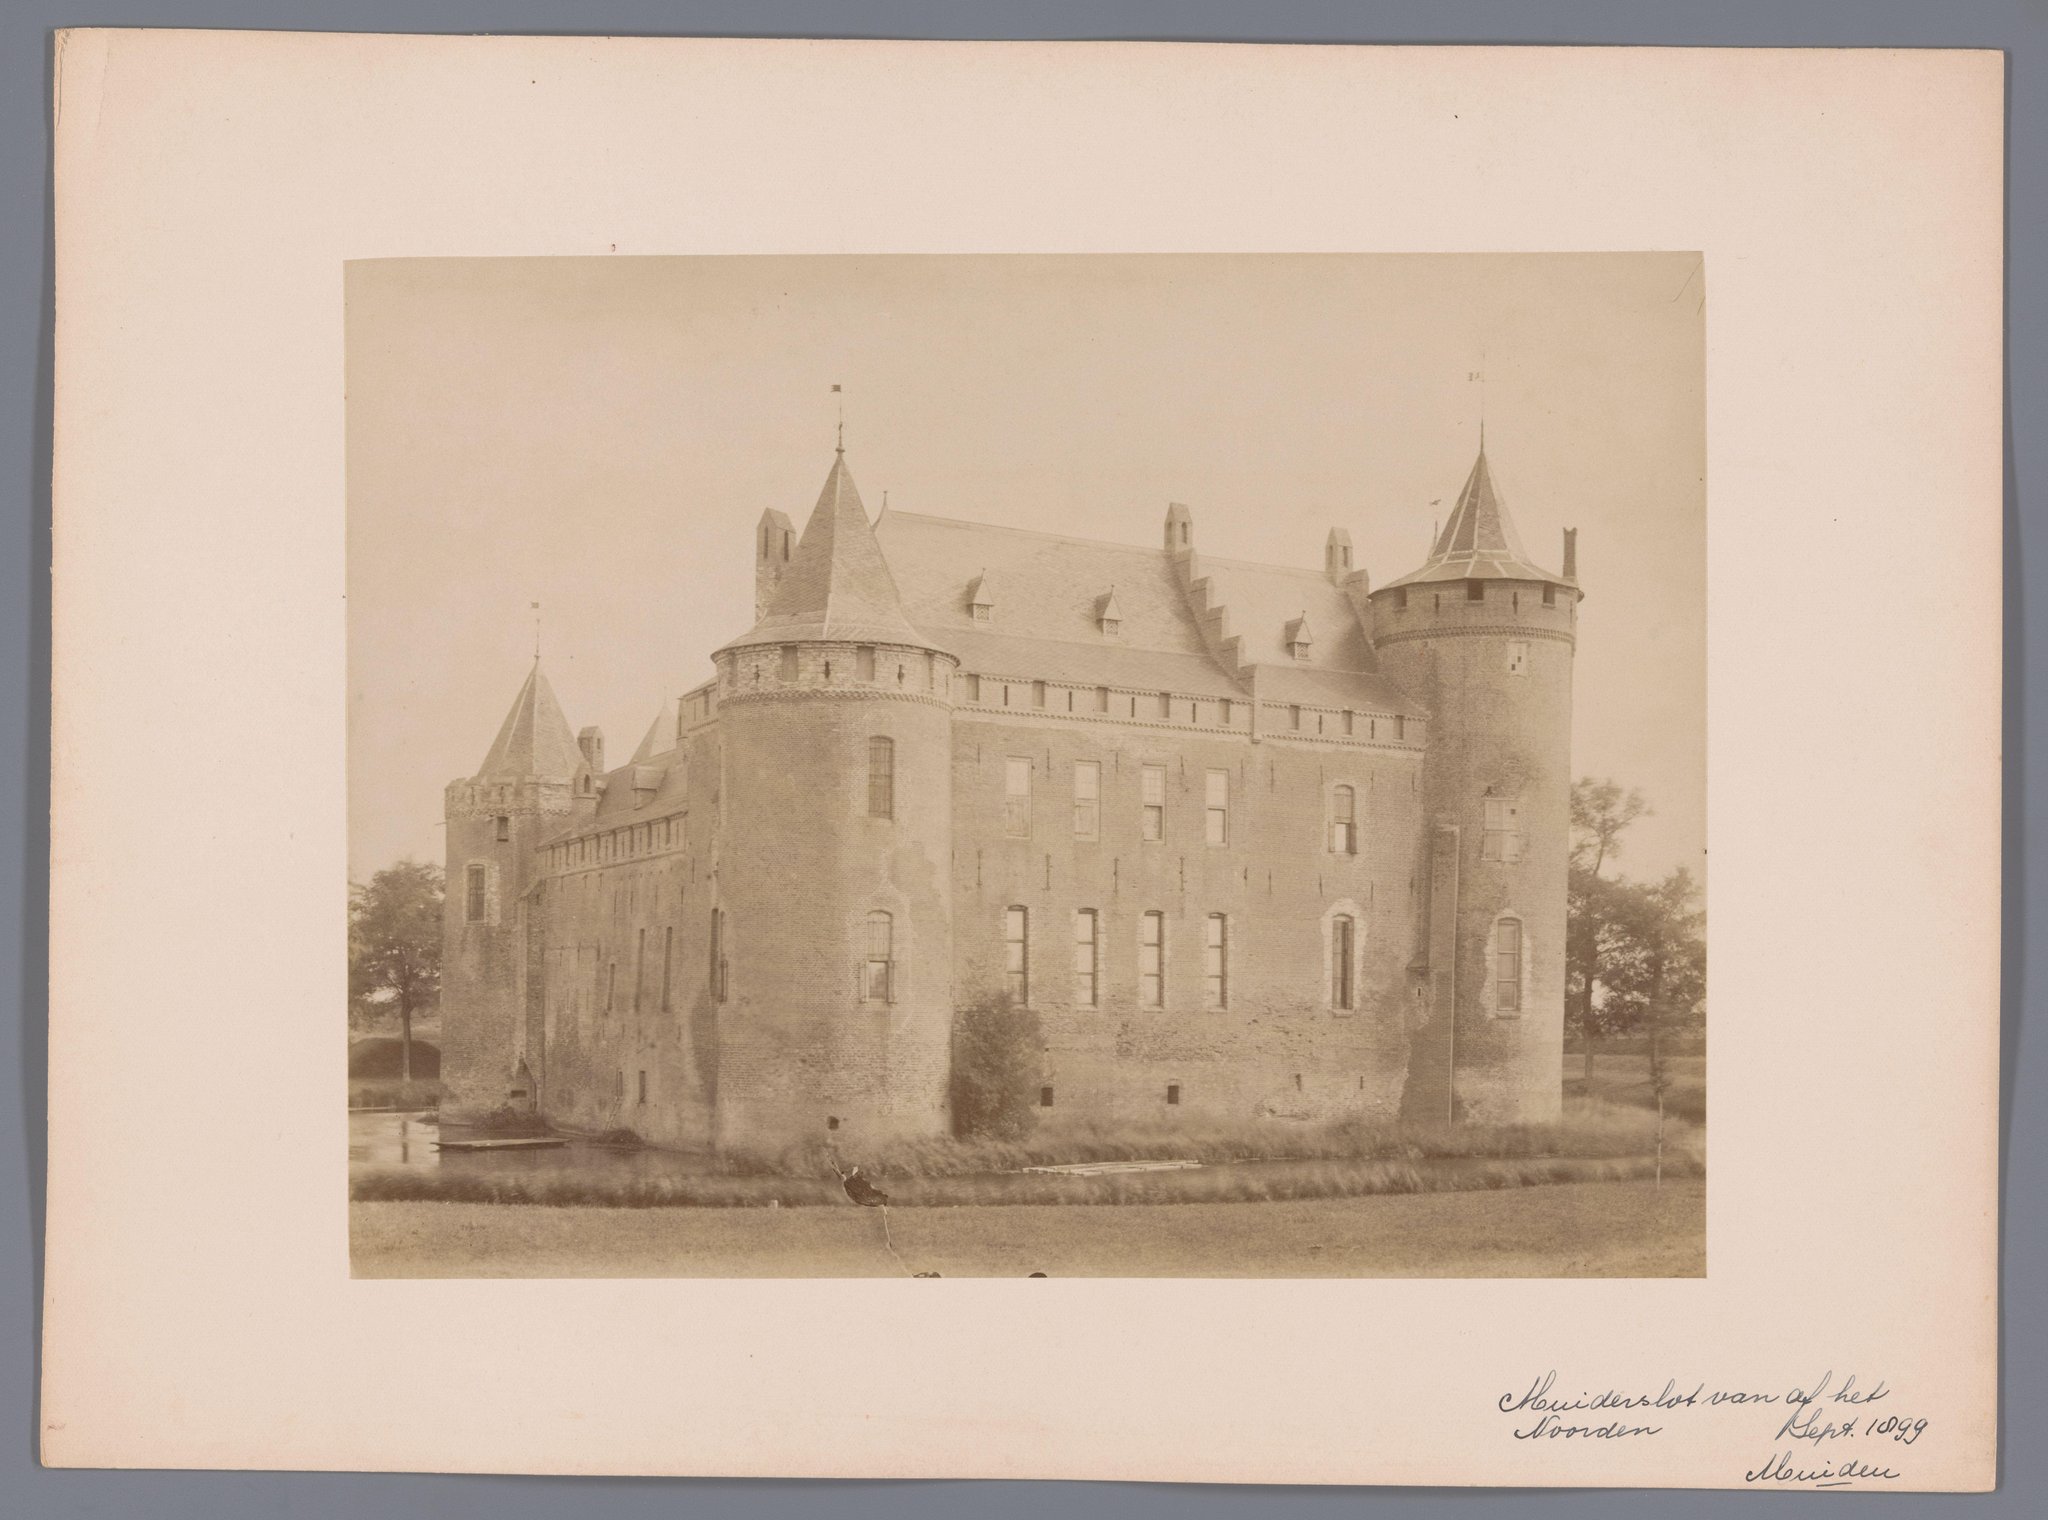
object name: photograph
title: Gezicht op het Muiderslot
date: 1899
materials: cardboard, photographic support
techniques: albumen print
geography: muiden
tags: castle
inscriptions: annotation: ‘Muiderslot van af het Noorden Sept. 1899/ Muiden’, annotation: ‘Slot te Muiden (N.H.)/ gezien van af het noorden/ sept 1899’